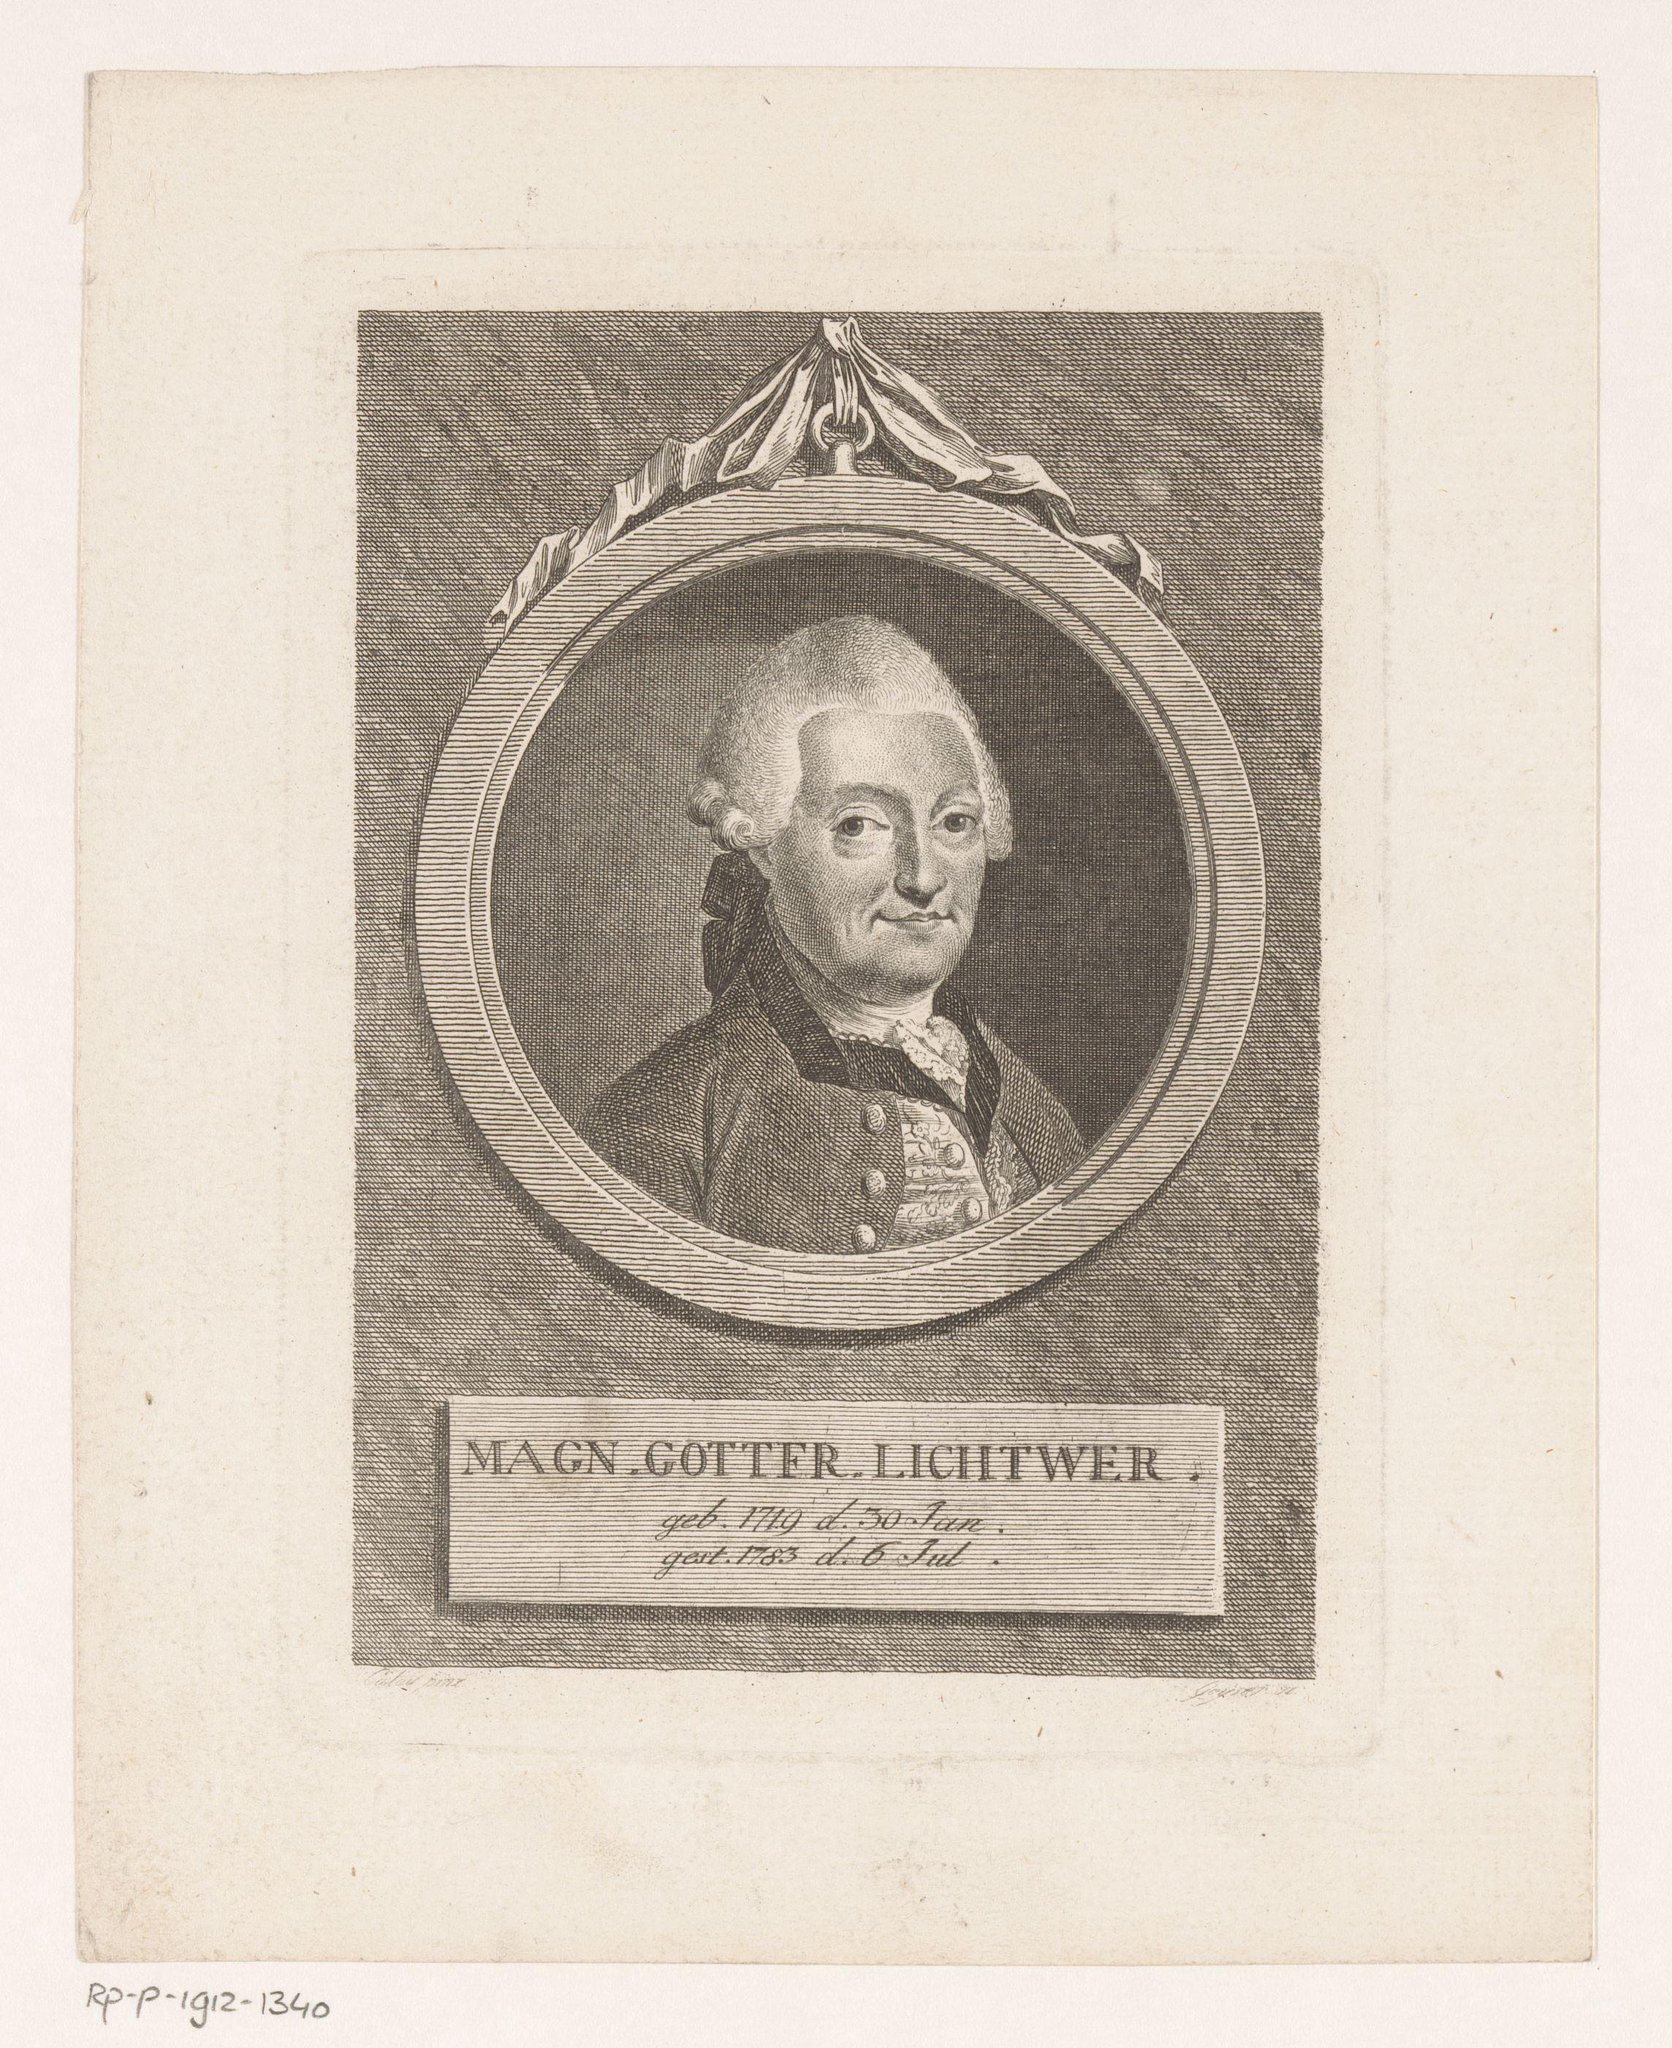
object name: print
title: Portret van Magnus Gottfried Lichtwer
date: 1783-1803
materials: paper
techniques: engraving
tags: ornament ~ medallion, historical persons, writer, poet, author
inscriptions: collector's mark: Lugt 2228